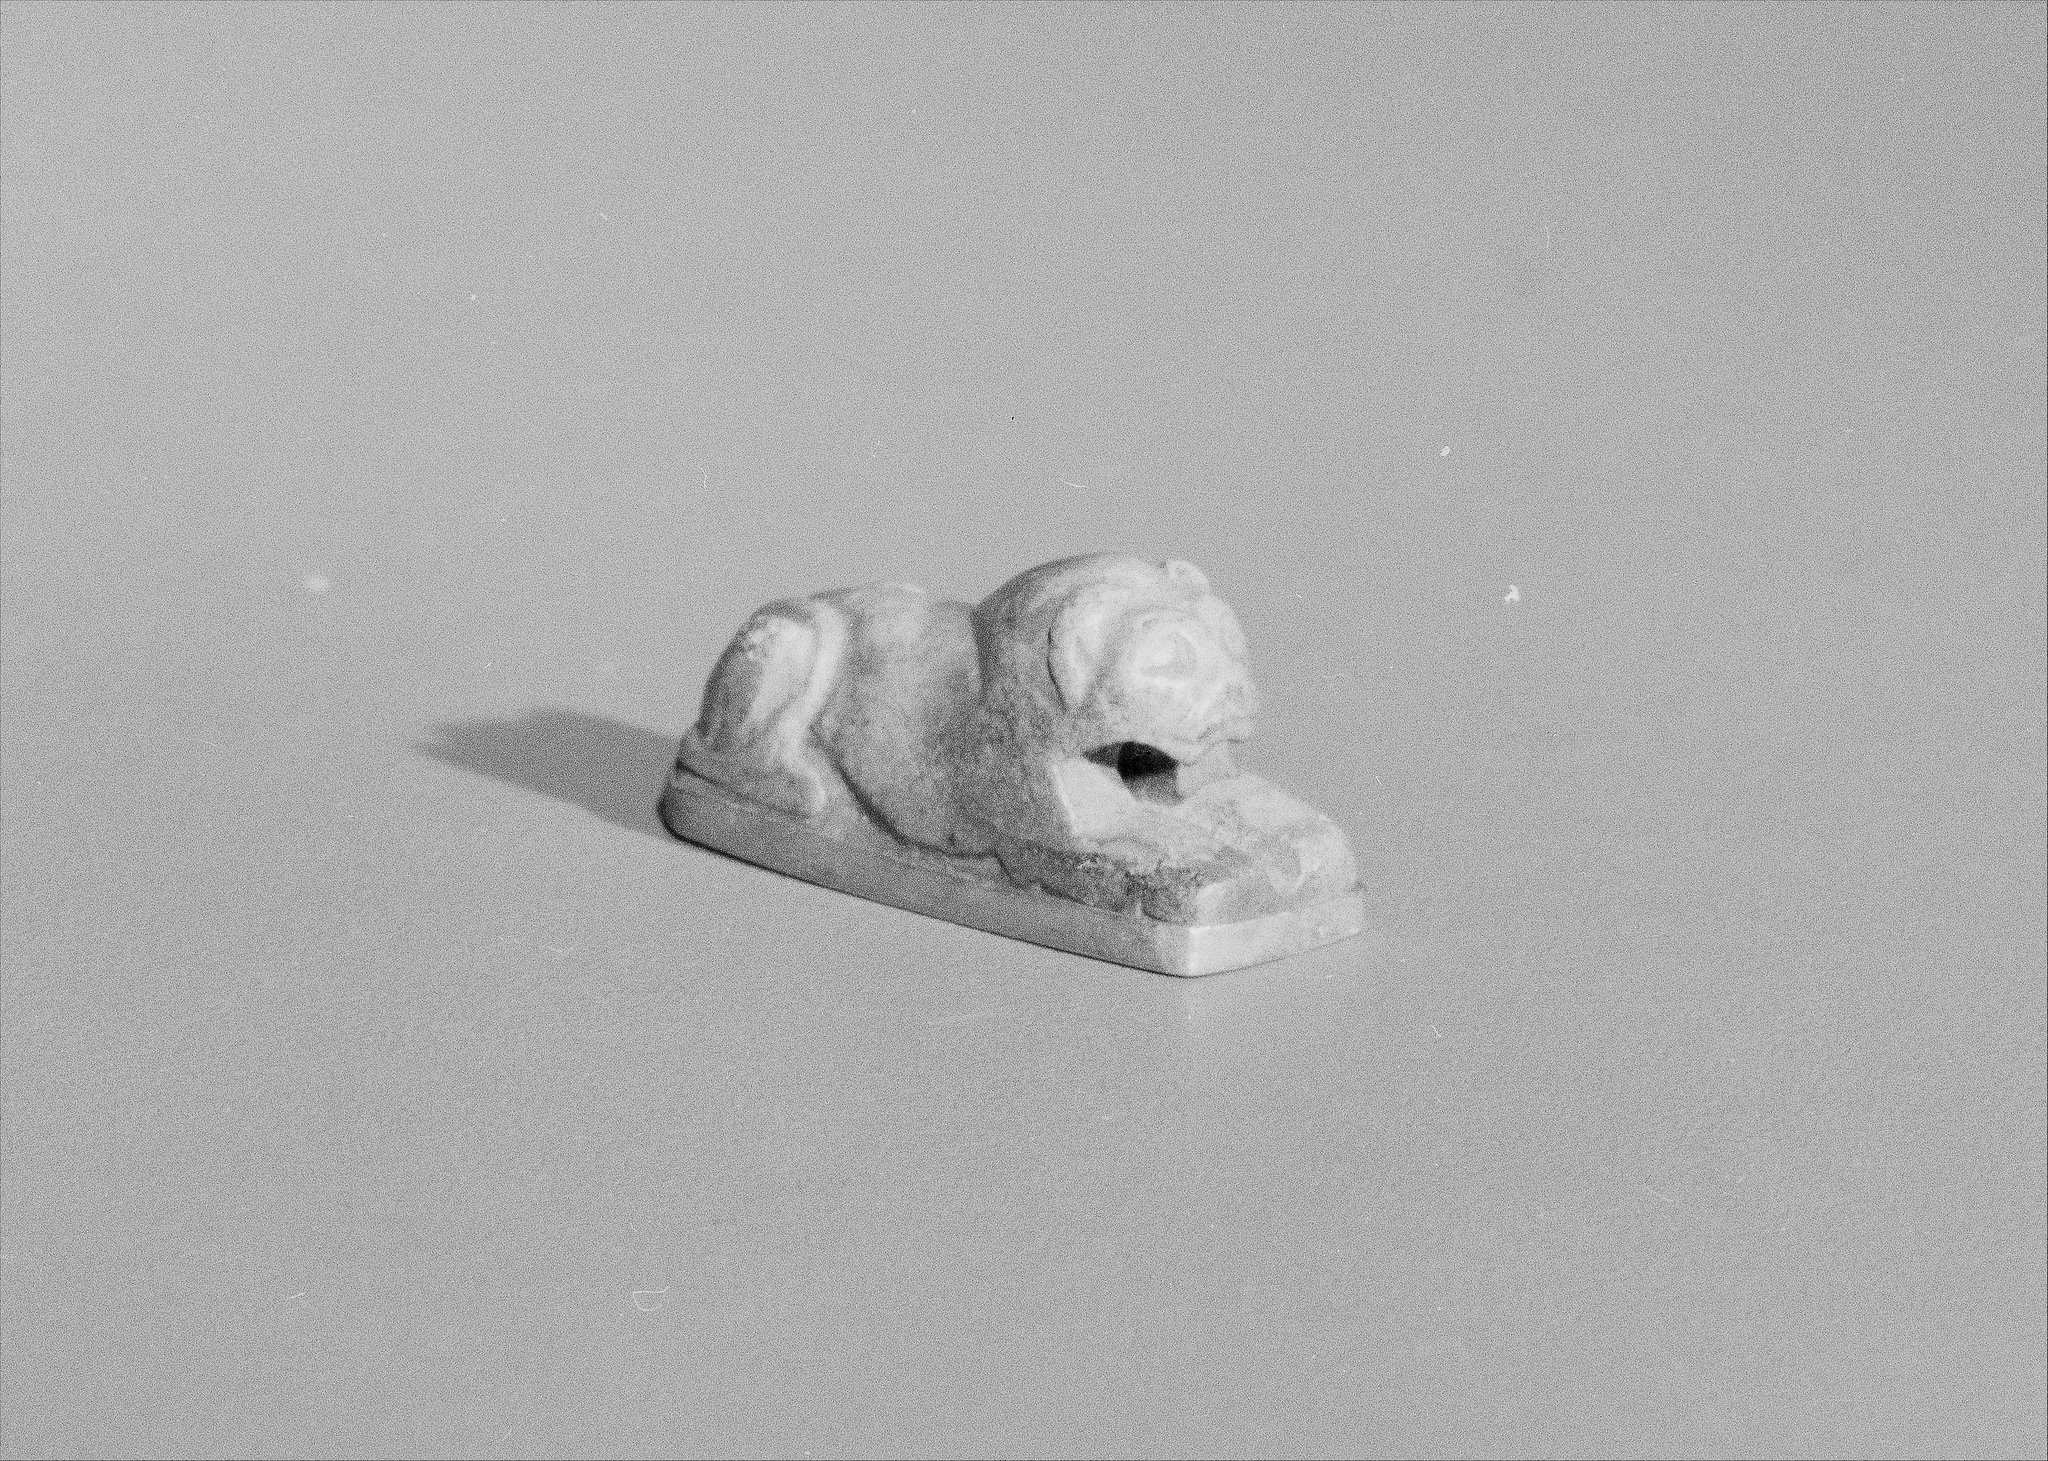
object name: amulet, lion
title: Recumbent Lion from a Bracelet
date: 1648-1540 BCE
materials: gold, stone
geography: eastern delta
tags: lions